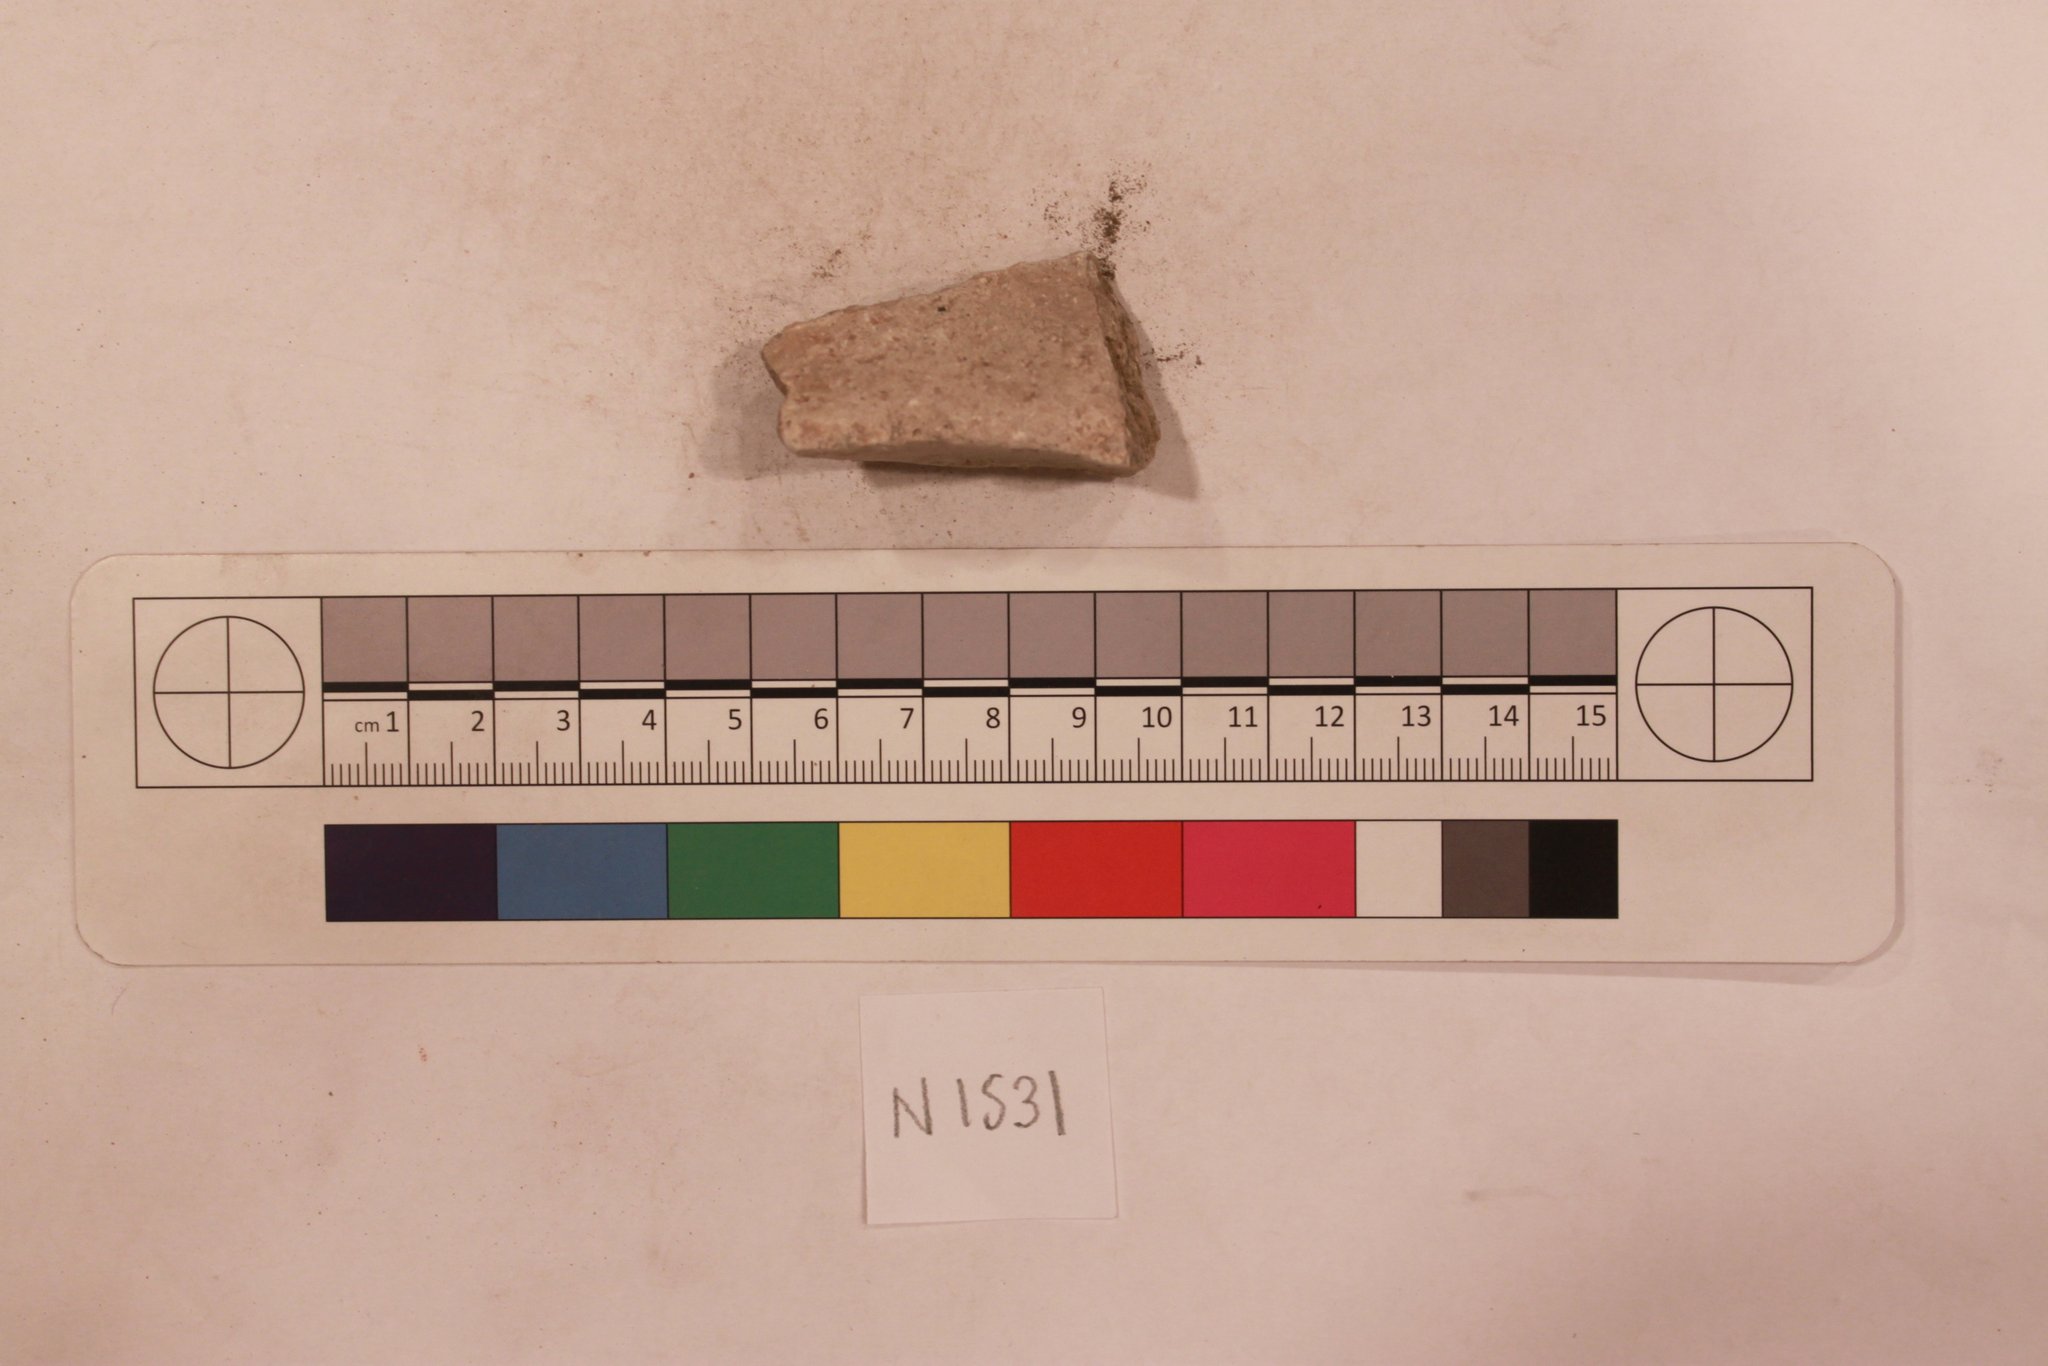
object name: fragment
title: Stucco Fragment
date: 701-1200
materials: plaster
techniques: carving, painting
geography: iran